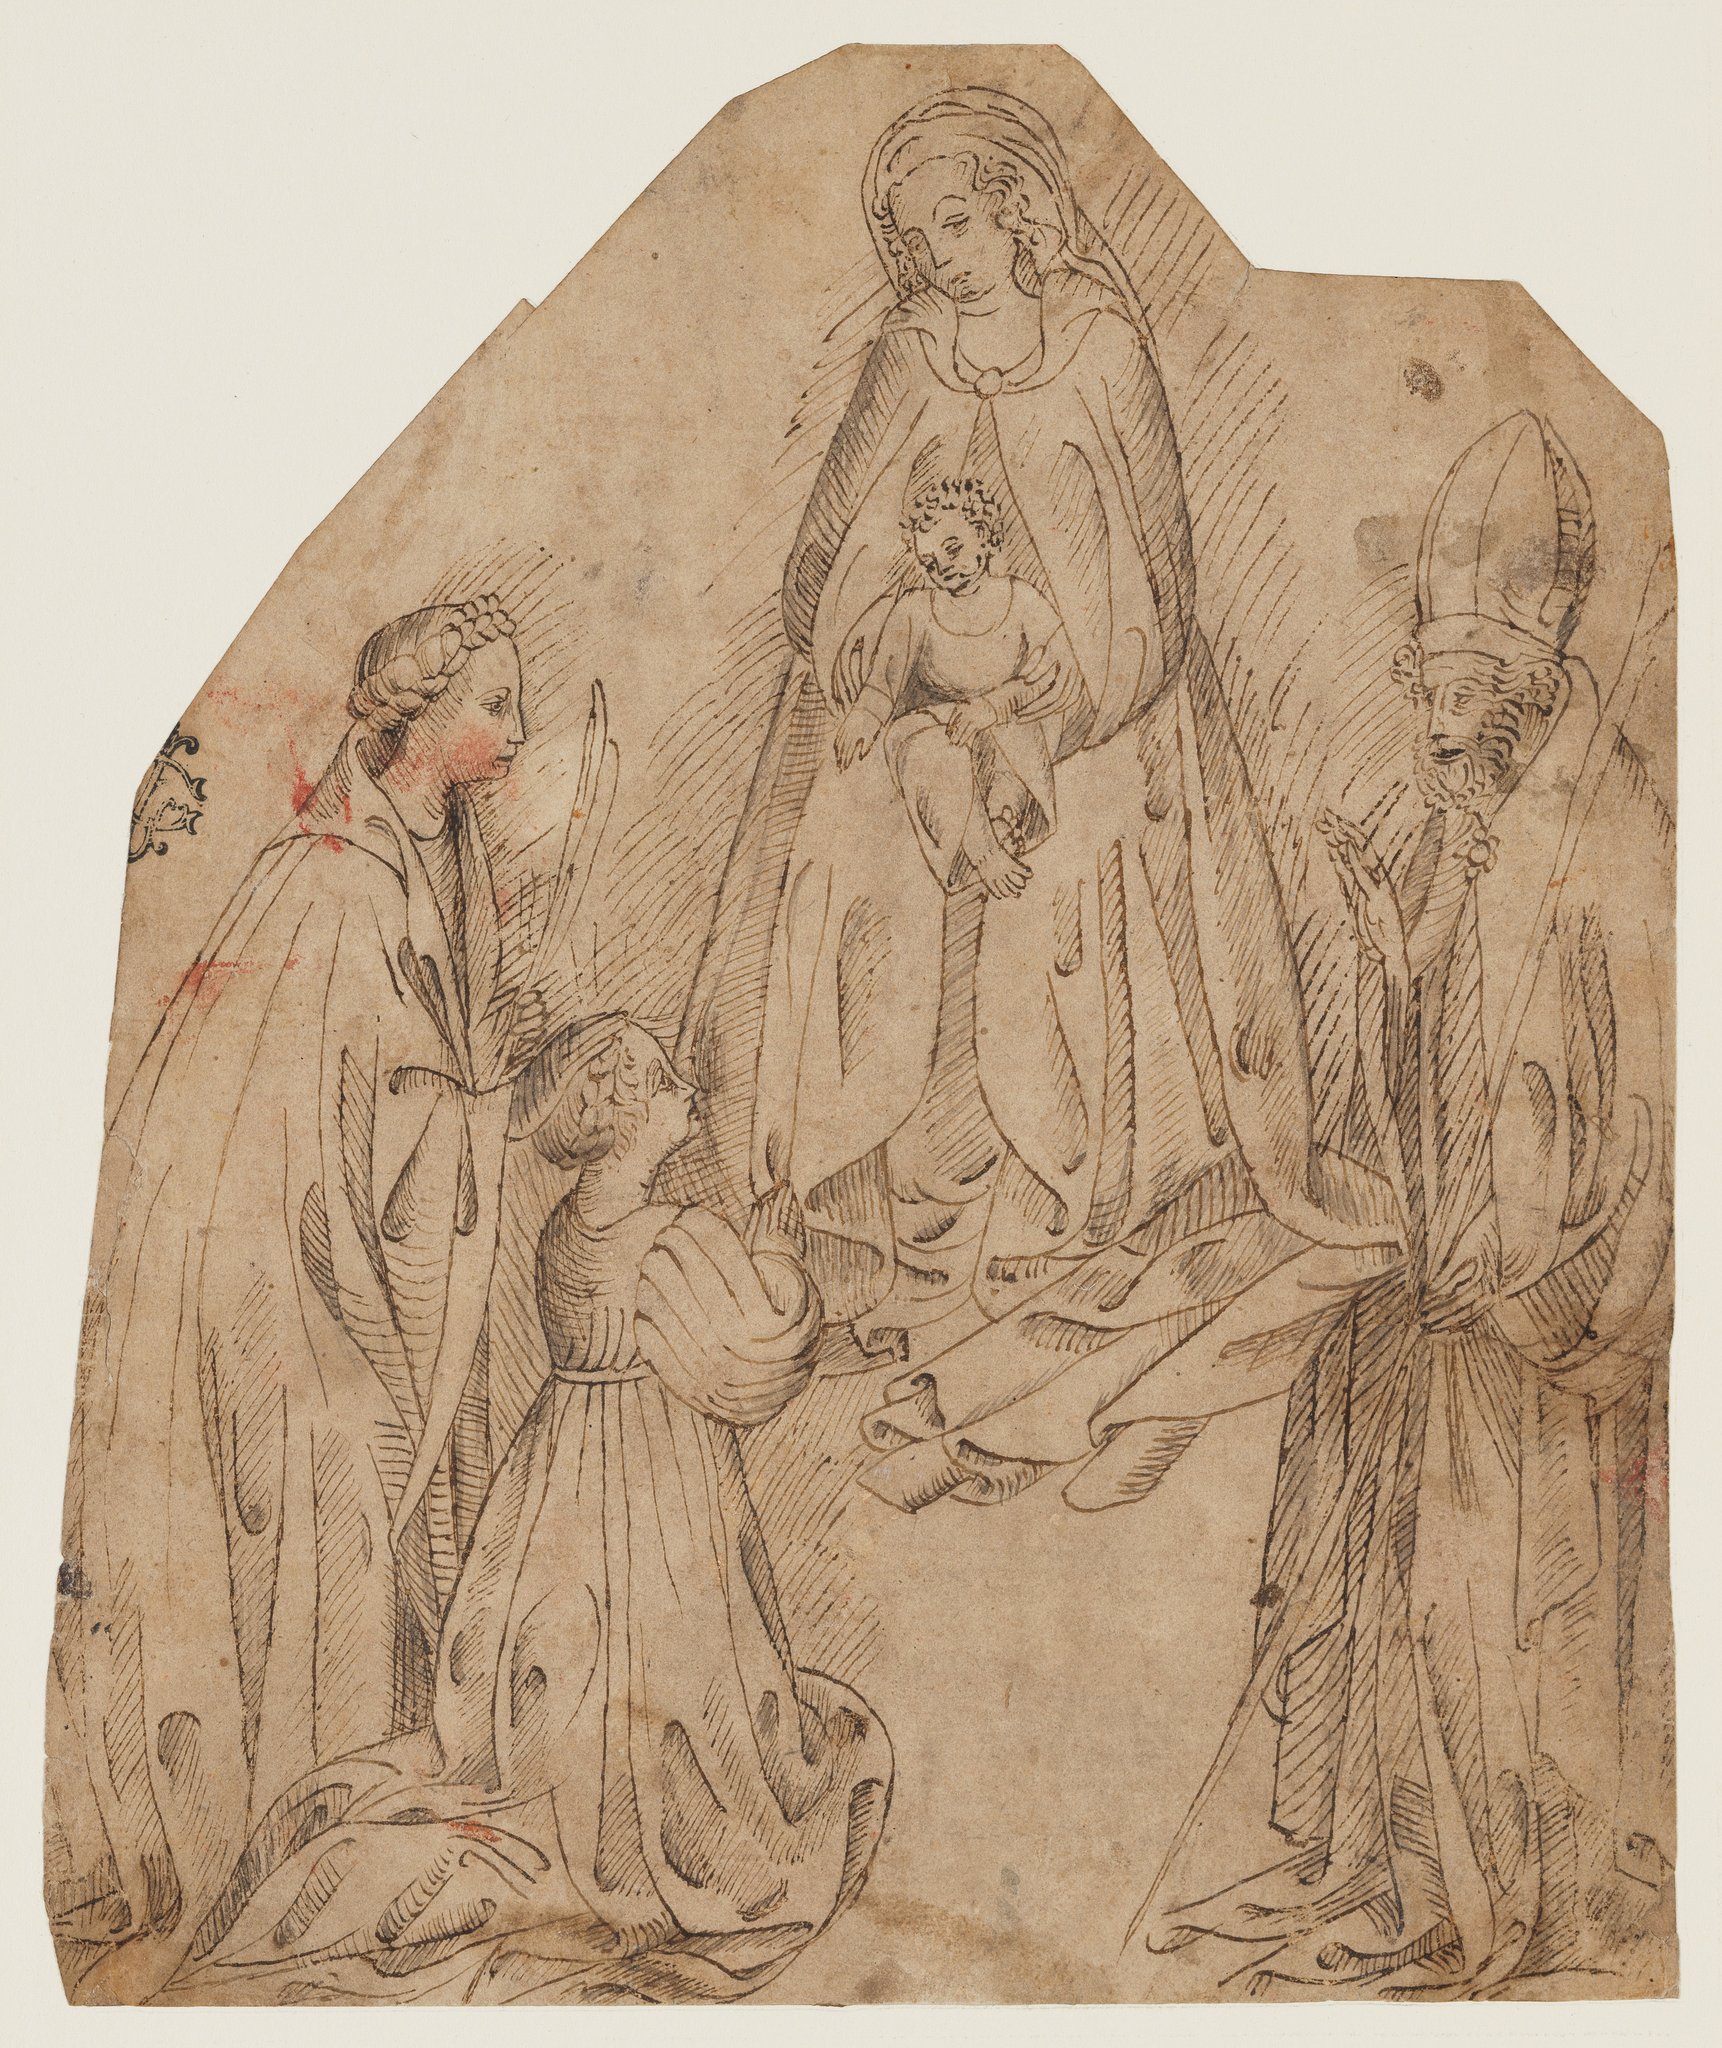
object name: drawing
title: The Madonna and Child with a Female Martyr Saint, a Bishop Saint, and a Female Donor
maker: stefano da verona (stefano di giovanni d'arbosio di francia)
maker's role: artist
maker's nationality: italian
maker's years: 1374-1438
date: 1401-1450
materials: ink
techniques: brush, pen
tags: women,bishops,madonna and child,saints